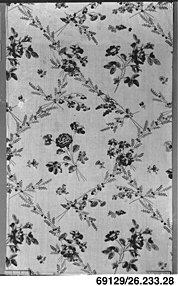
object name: piece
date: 1701-1800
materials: cotton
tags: flowers,leaves